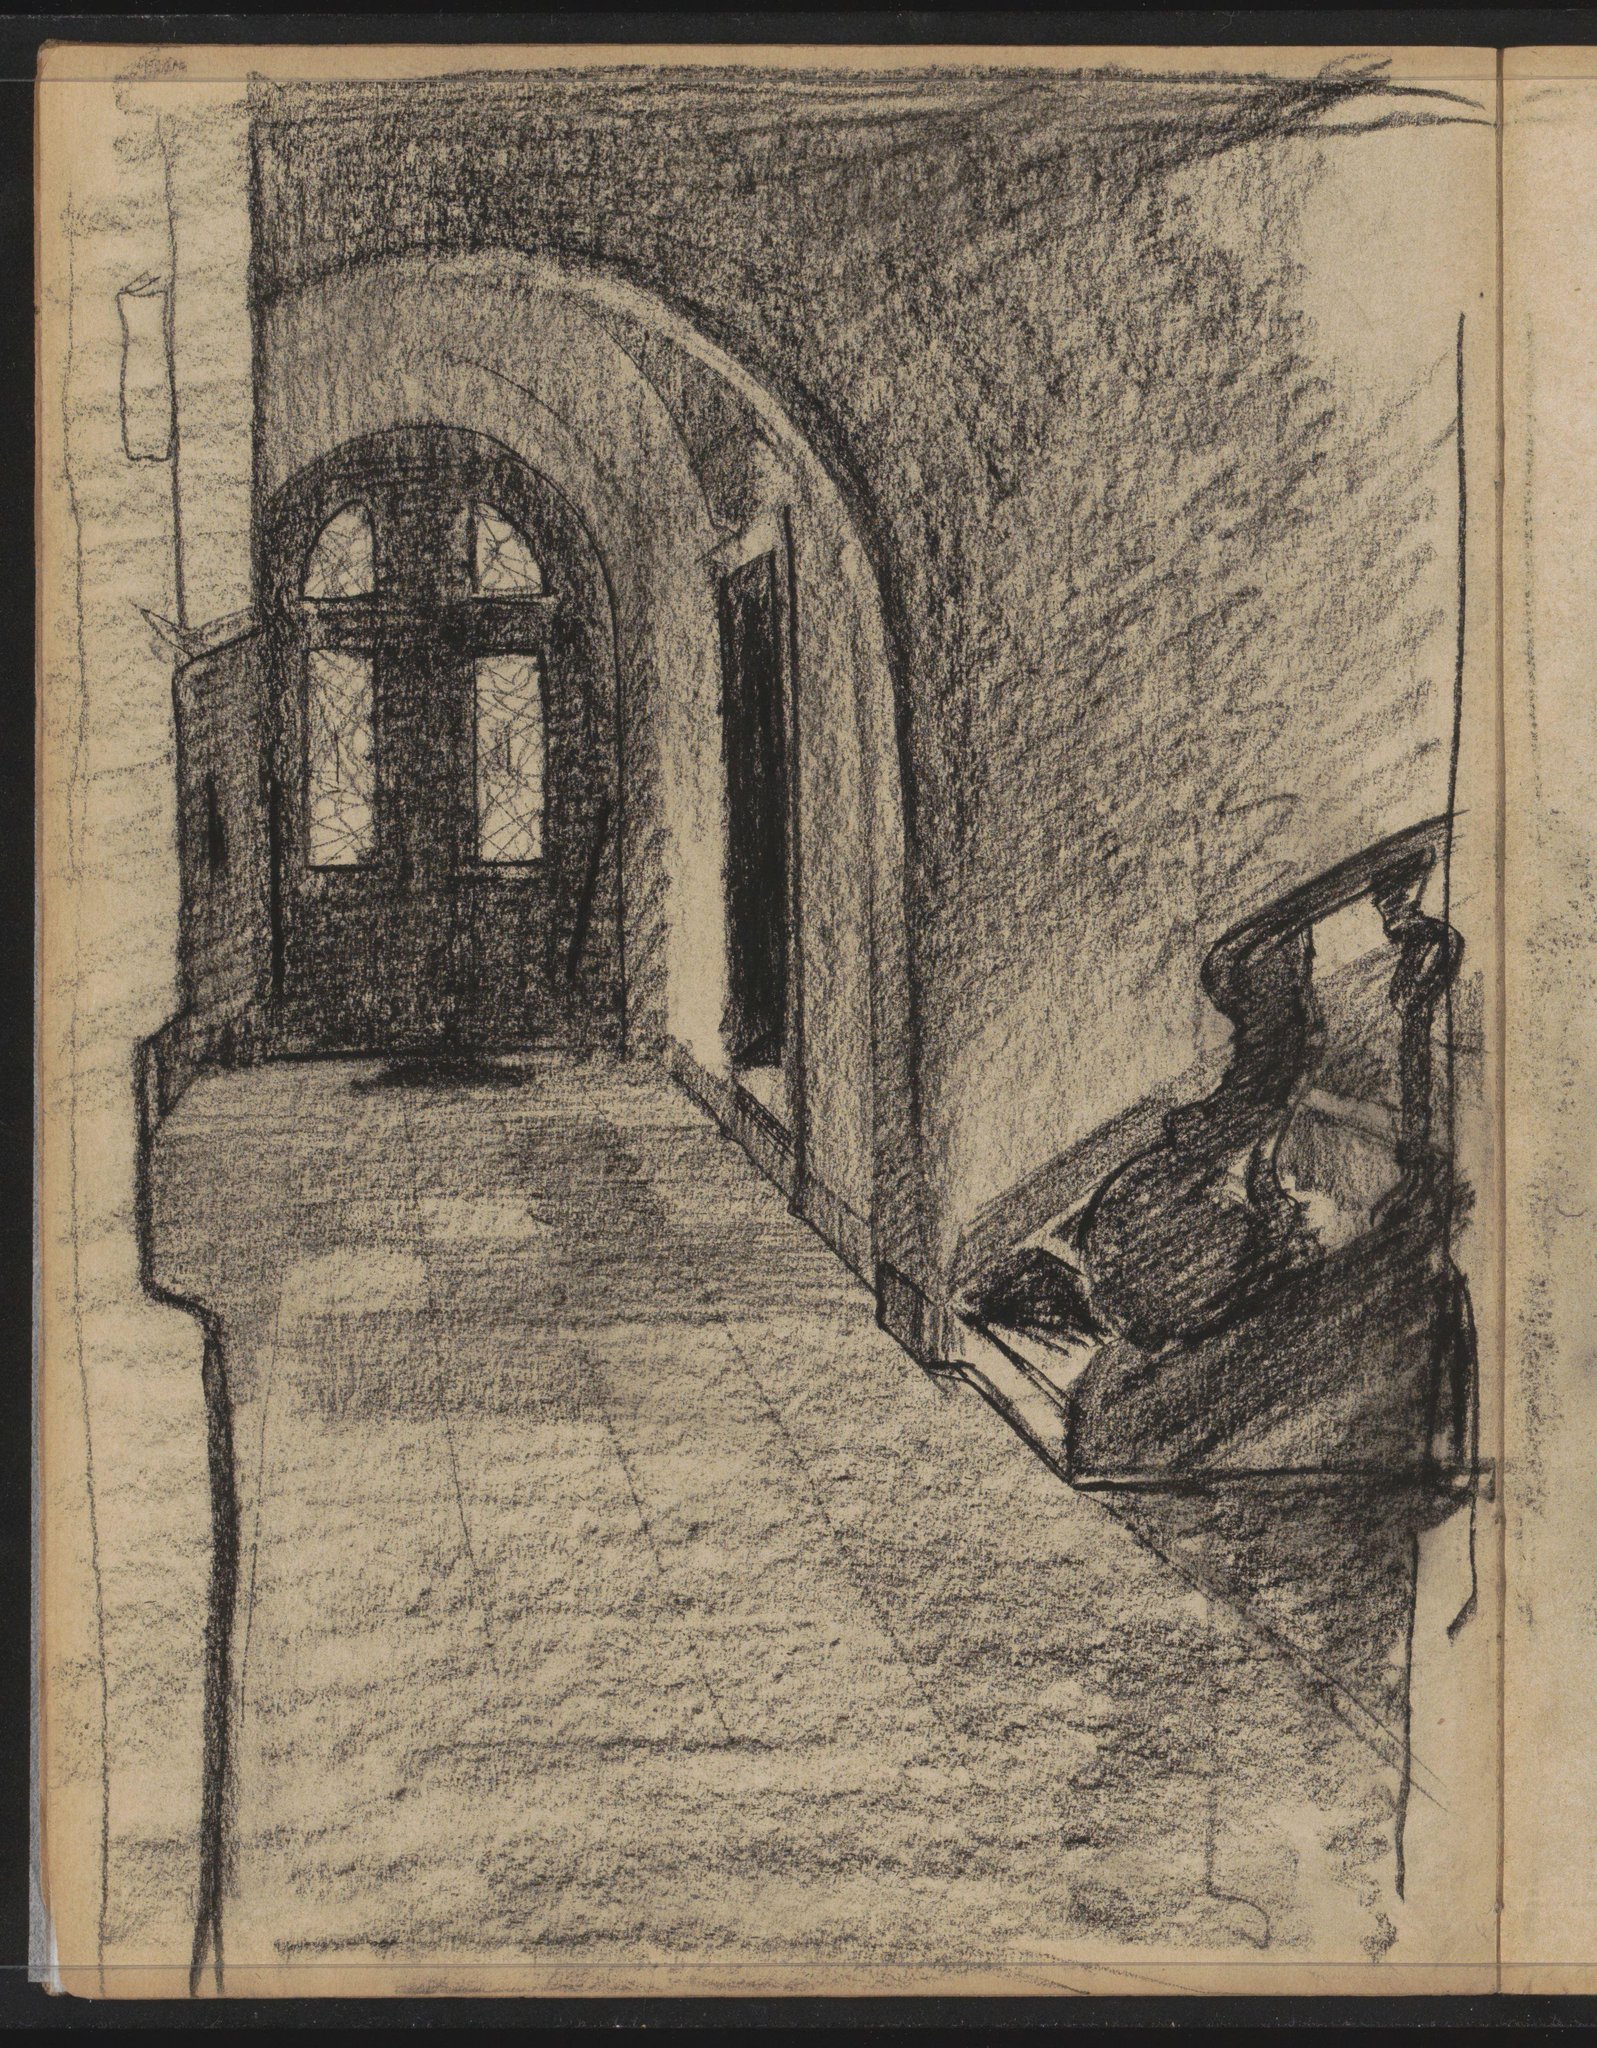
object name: sketchbook leaf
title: Hal, mogelijk van Kasteel Warmelo te Diepenheim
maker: willem witsen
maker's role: draughtsman, painter, print maker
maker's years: 1860-1923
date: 1887-1888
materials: chalk, paper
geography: diepenheim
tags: vestibule, hall, staircase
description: Pagina 14 uit een schetsboek met 43 bladen.